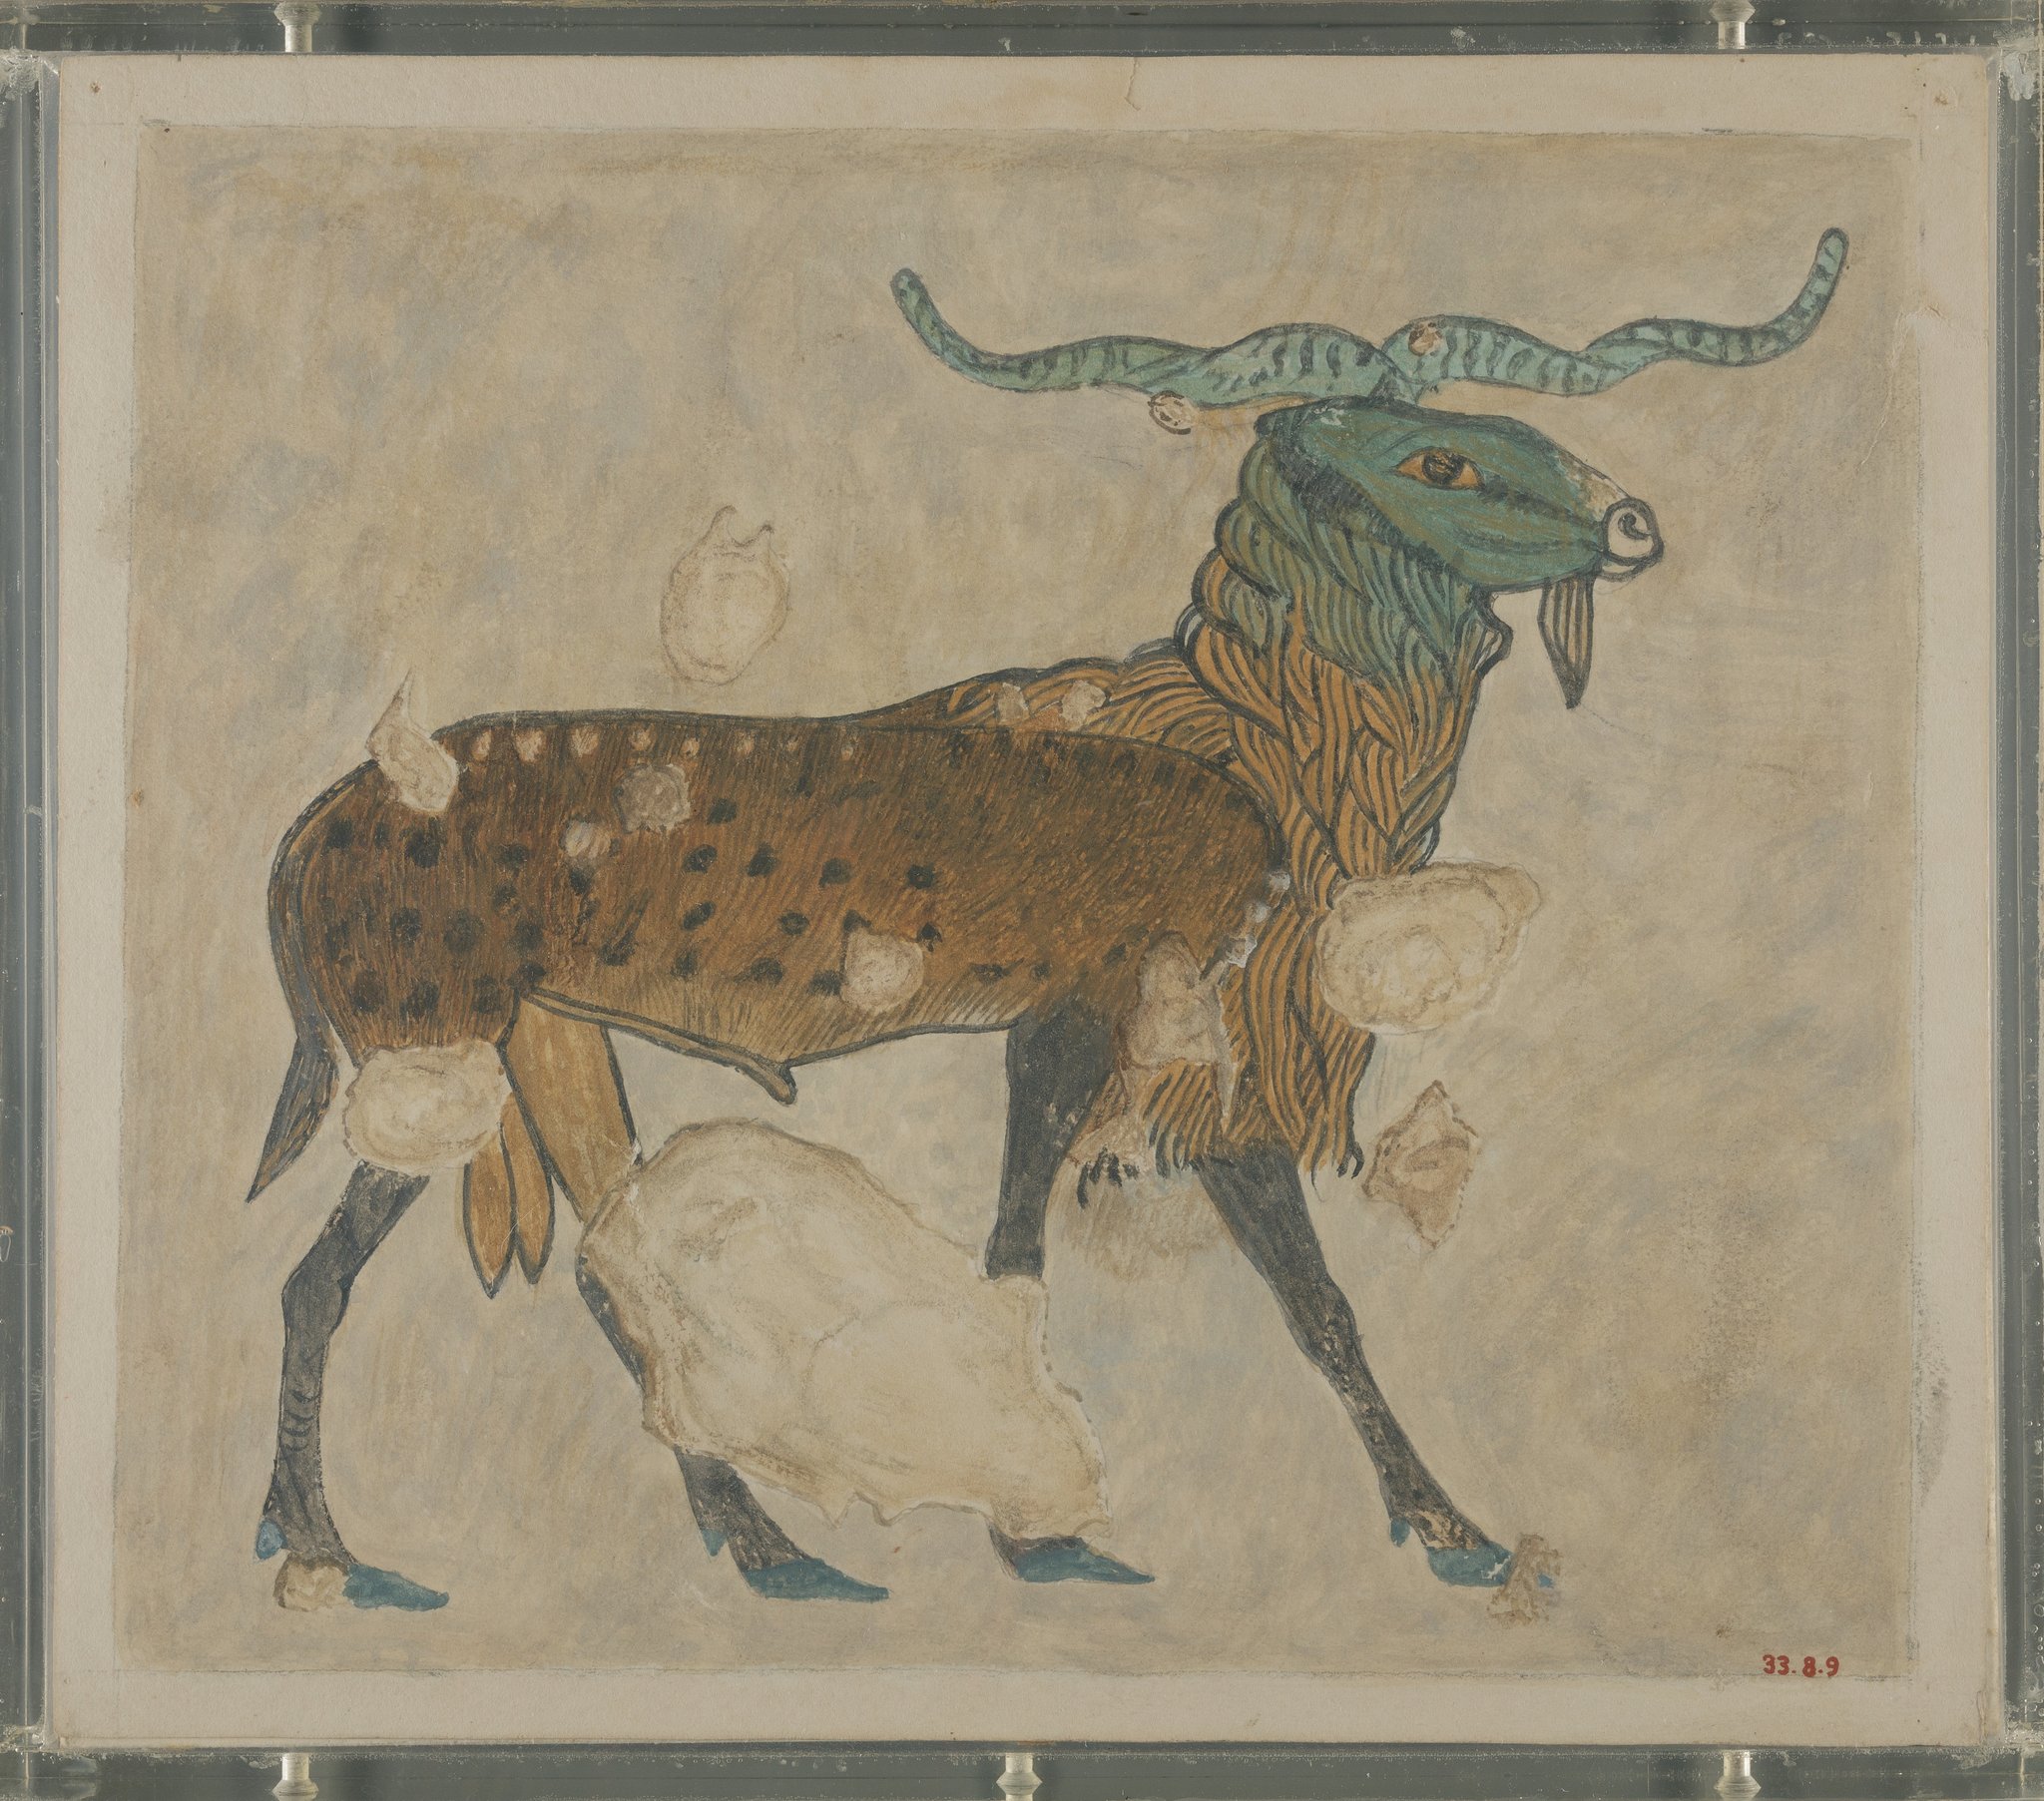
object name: facsimile, khnumhotep beni hasan 3, ram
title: Detail of a Ram, Tomb of Khnumhotep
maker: nina de garis davies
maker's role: artist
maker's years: 1881-1965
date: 1897-1878 BCE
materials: paper, paint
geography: egypt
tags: rams